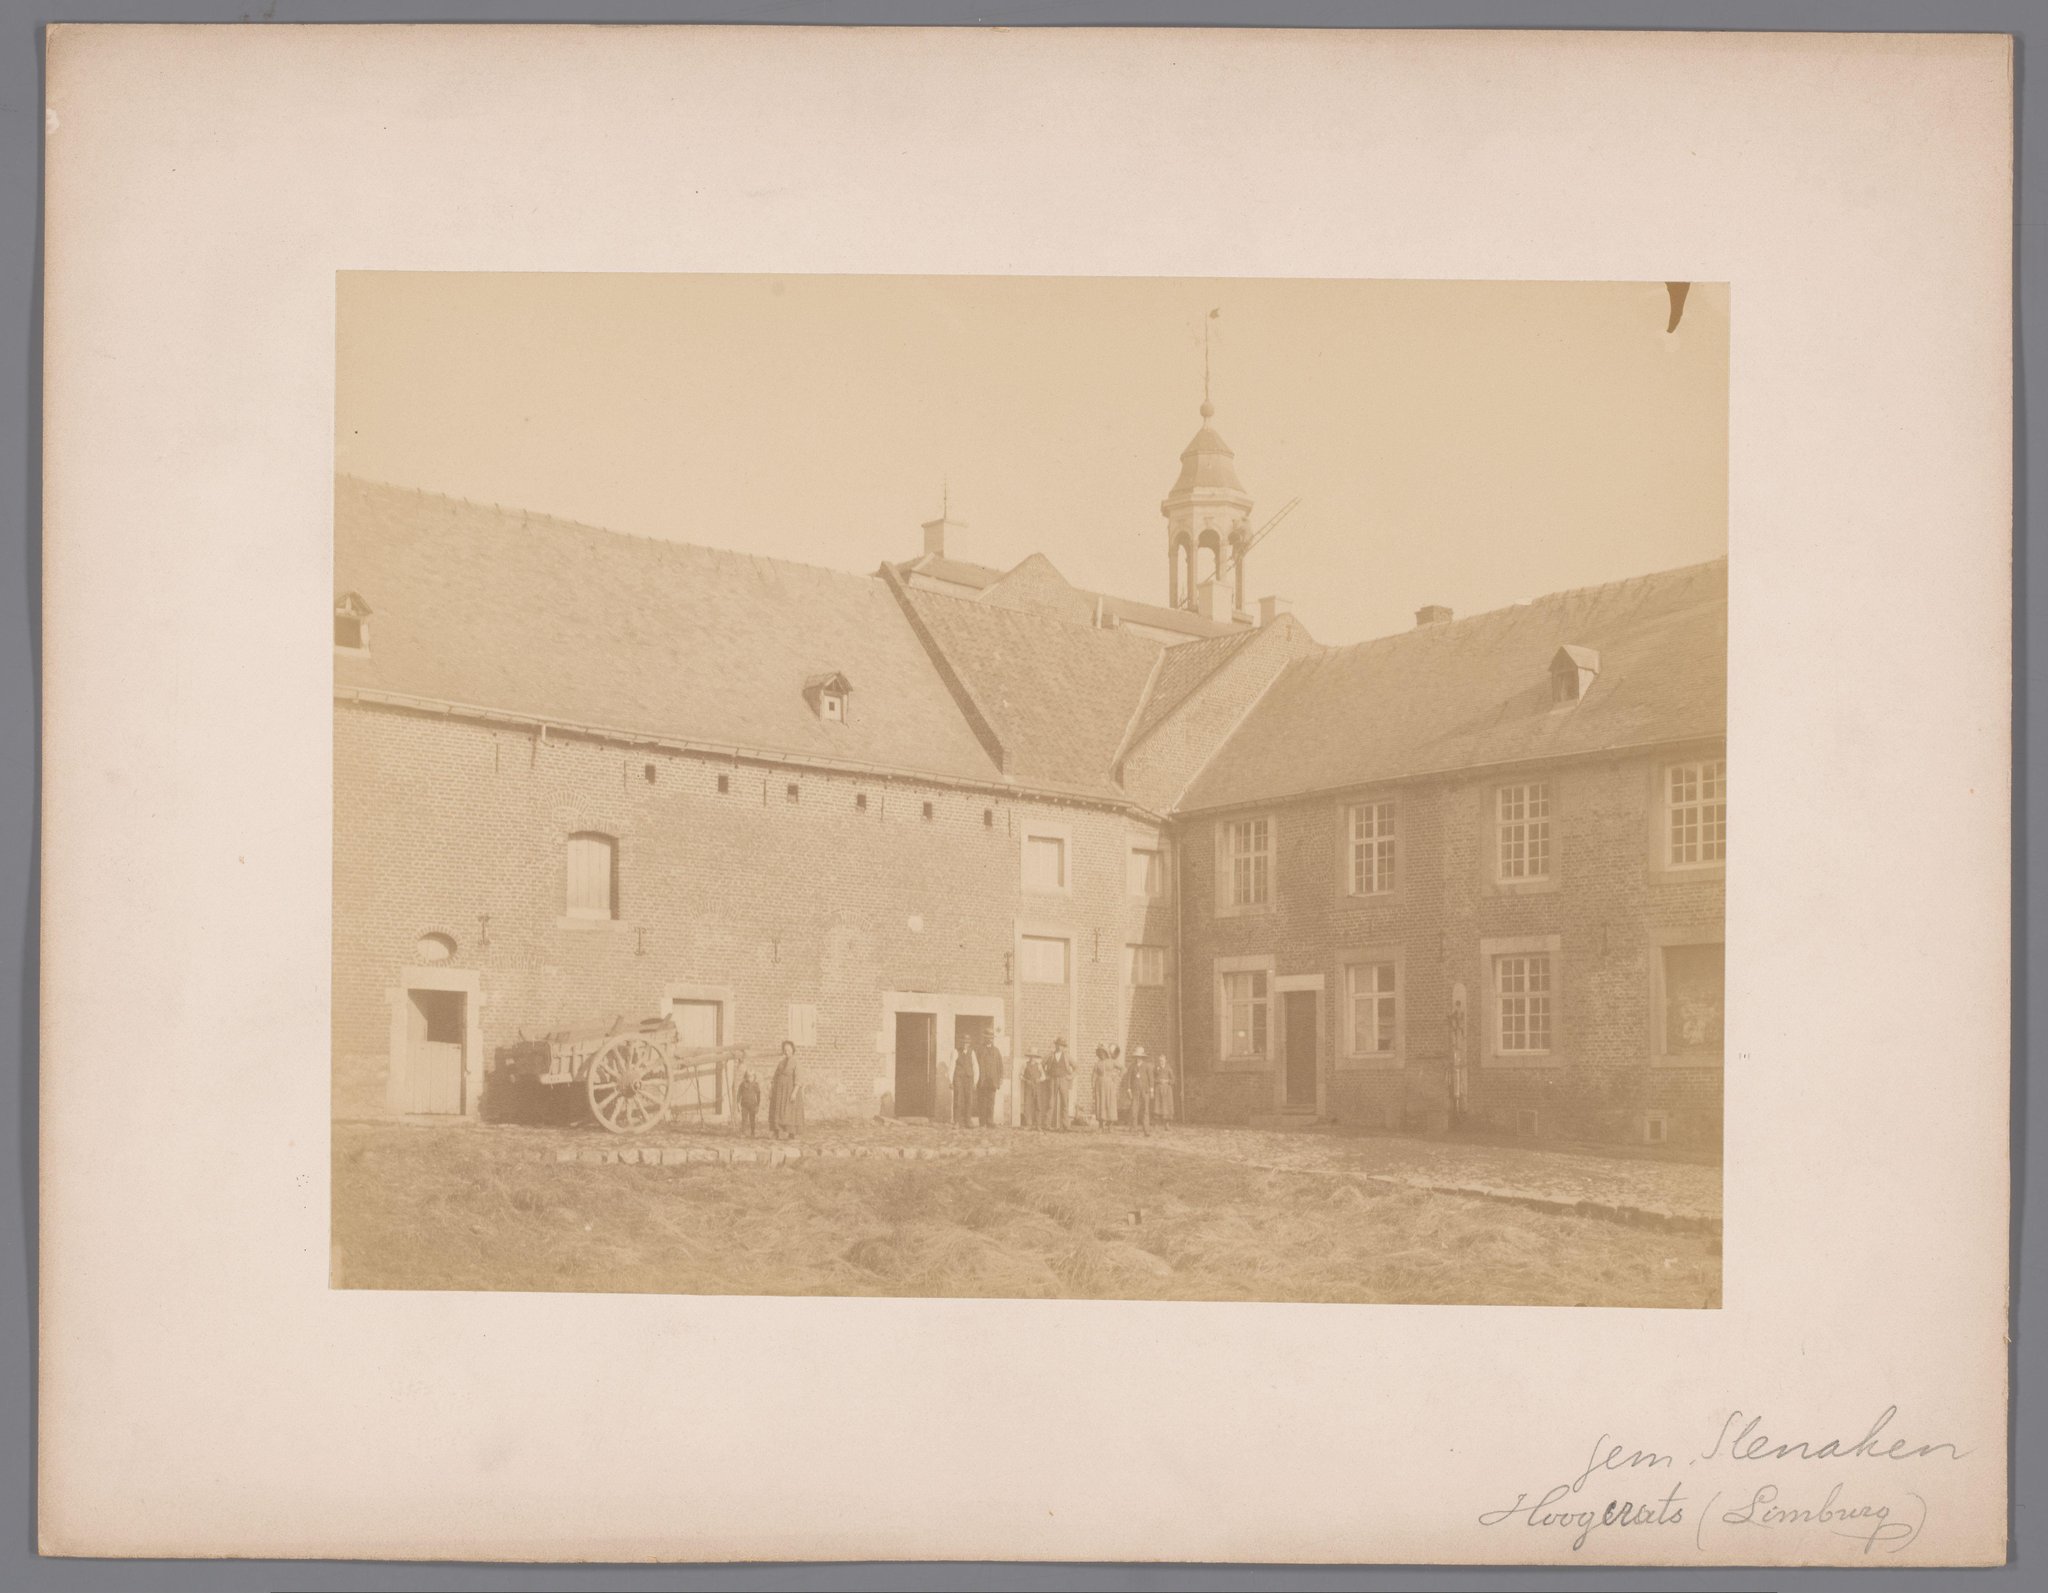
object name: photograph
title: Binnenplaats van het voormalige klooster te Hoogcruts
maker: anoniem (monumentenzorg)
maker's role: fotograaf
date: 1890-1920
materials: cardboard, photographic support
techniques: albumen print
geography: hoogcruts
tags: abbey, monastery, convent ~ roman catholic church, courtyard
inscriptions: annotation: ‘gem. Slenaken/ Hoogcruts (Limburg)’, annotation: ‘Binnenplaats v/h voormalige klooster te Hoogcuts (Limburg)/ bij Noorbeek’